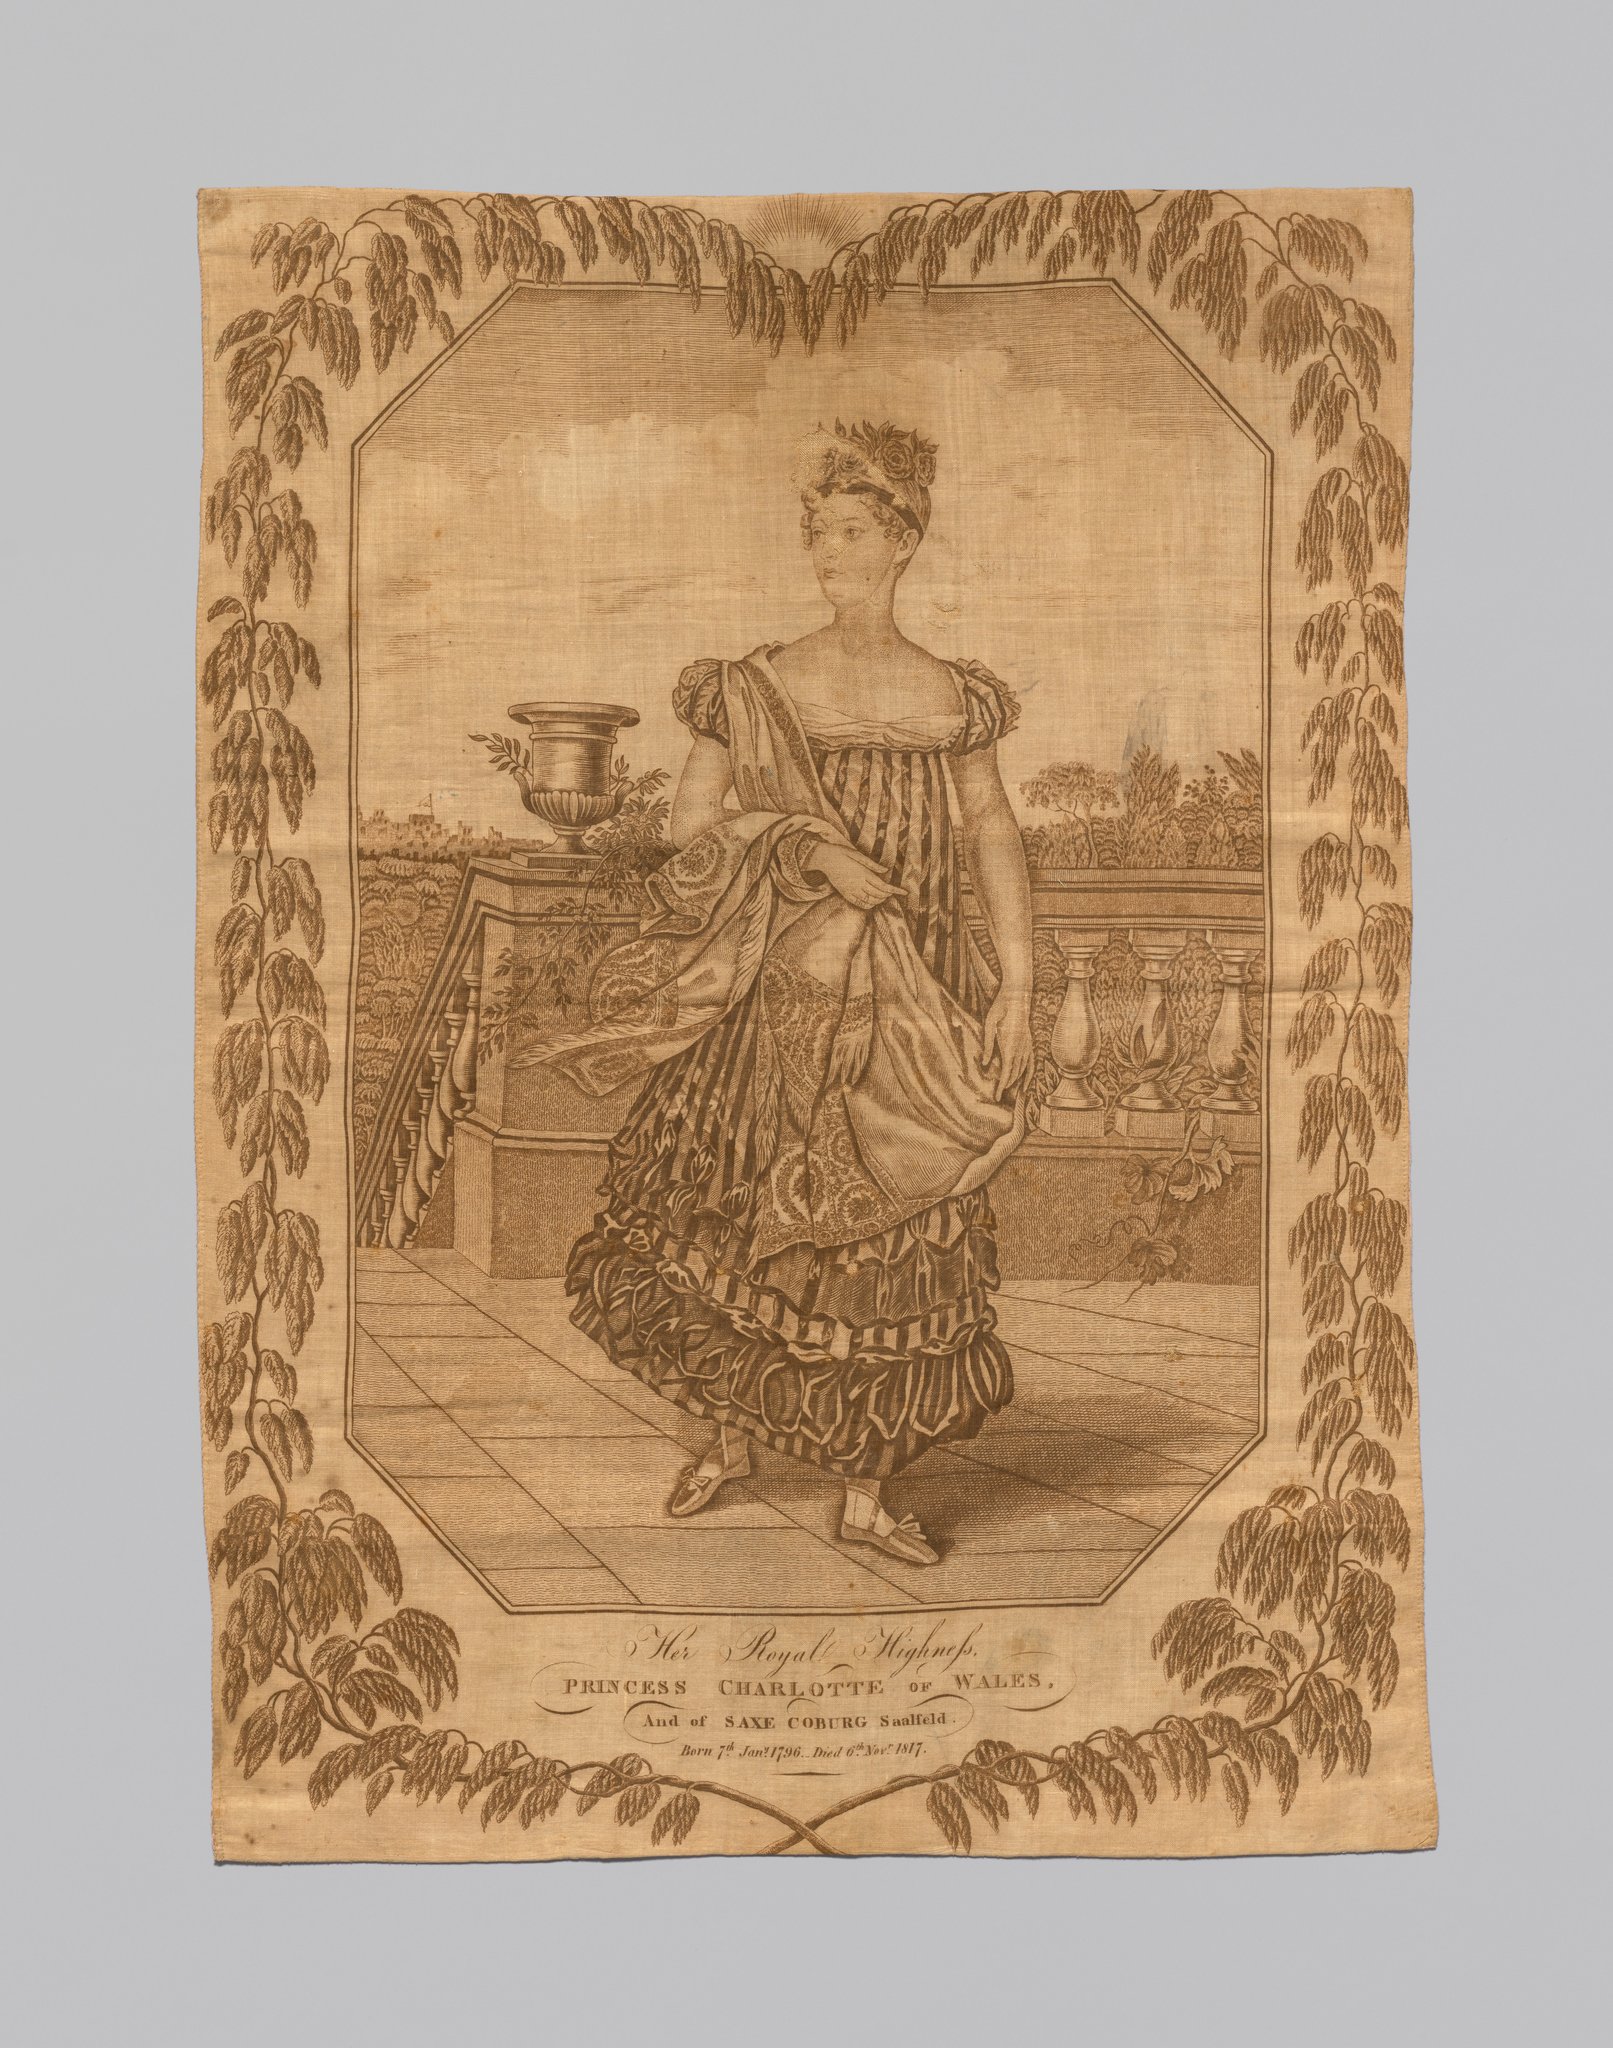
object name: handkerchief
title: Death of Princess Charlotte memorial handkerchief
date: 1817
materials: cotton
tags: women